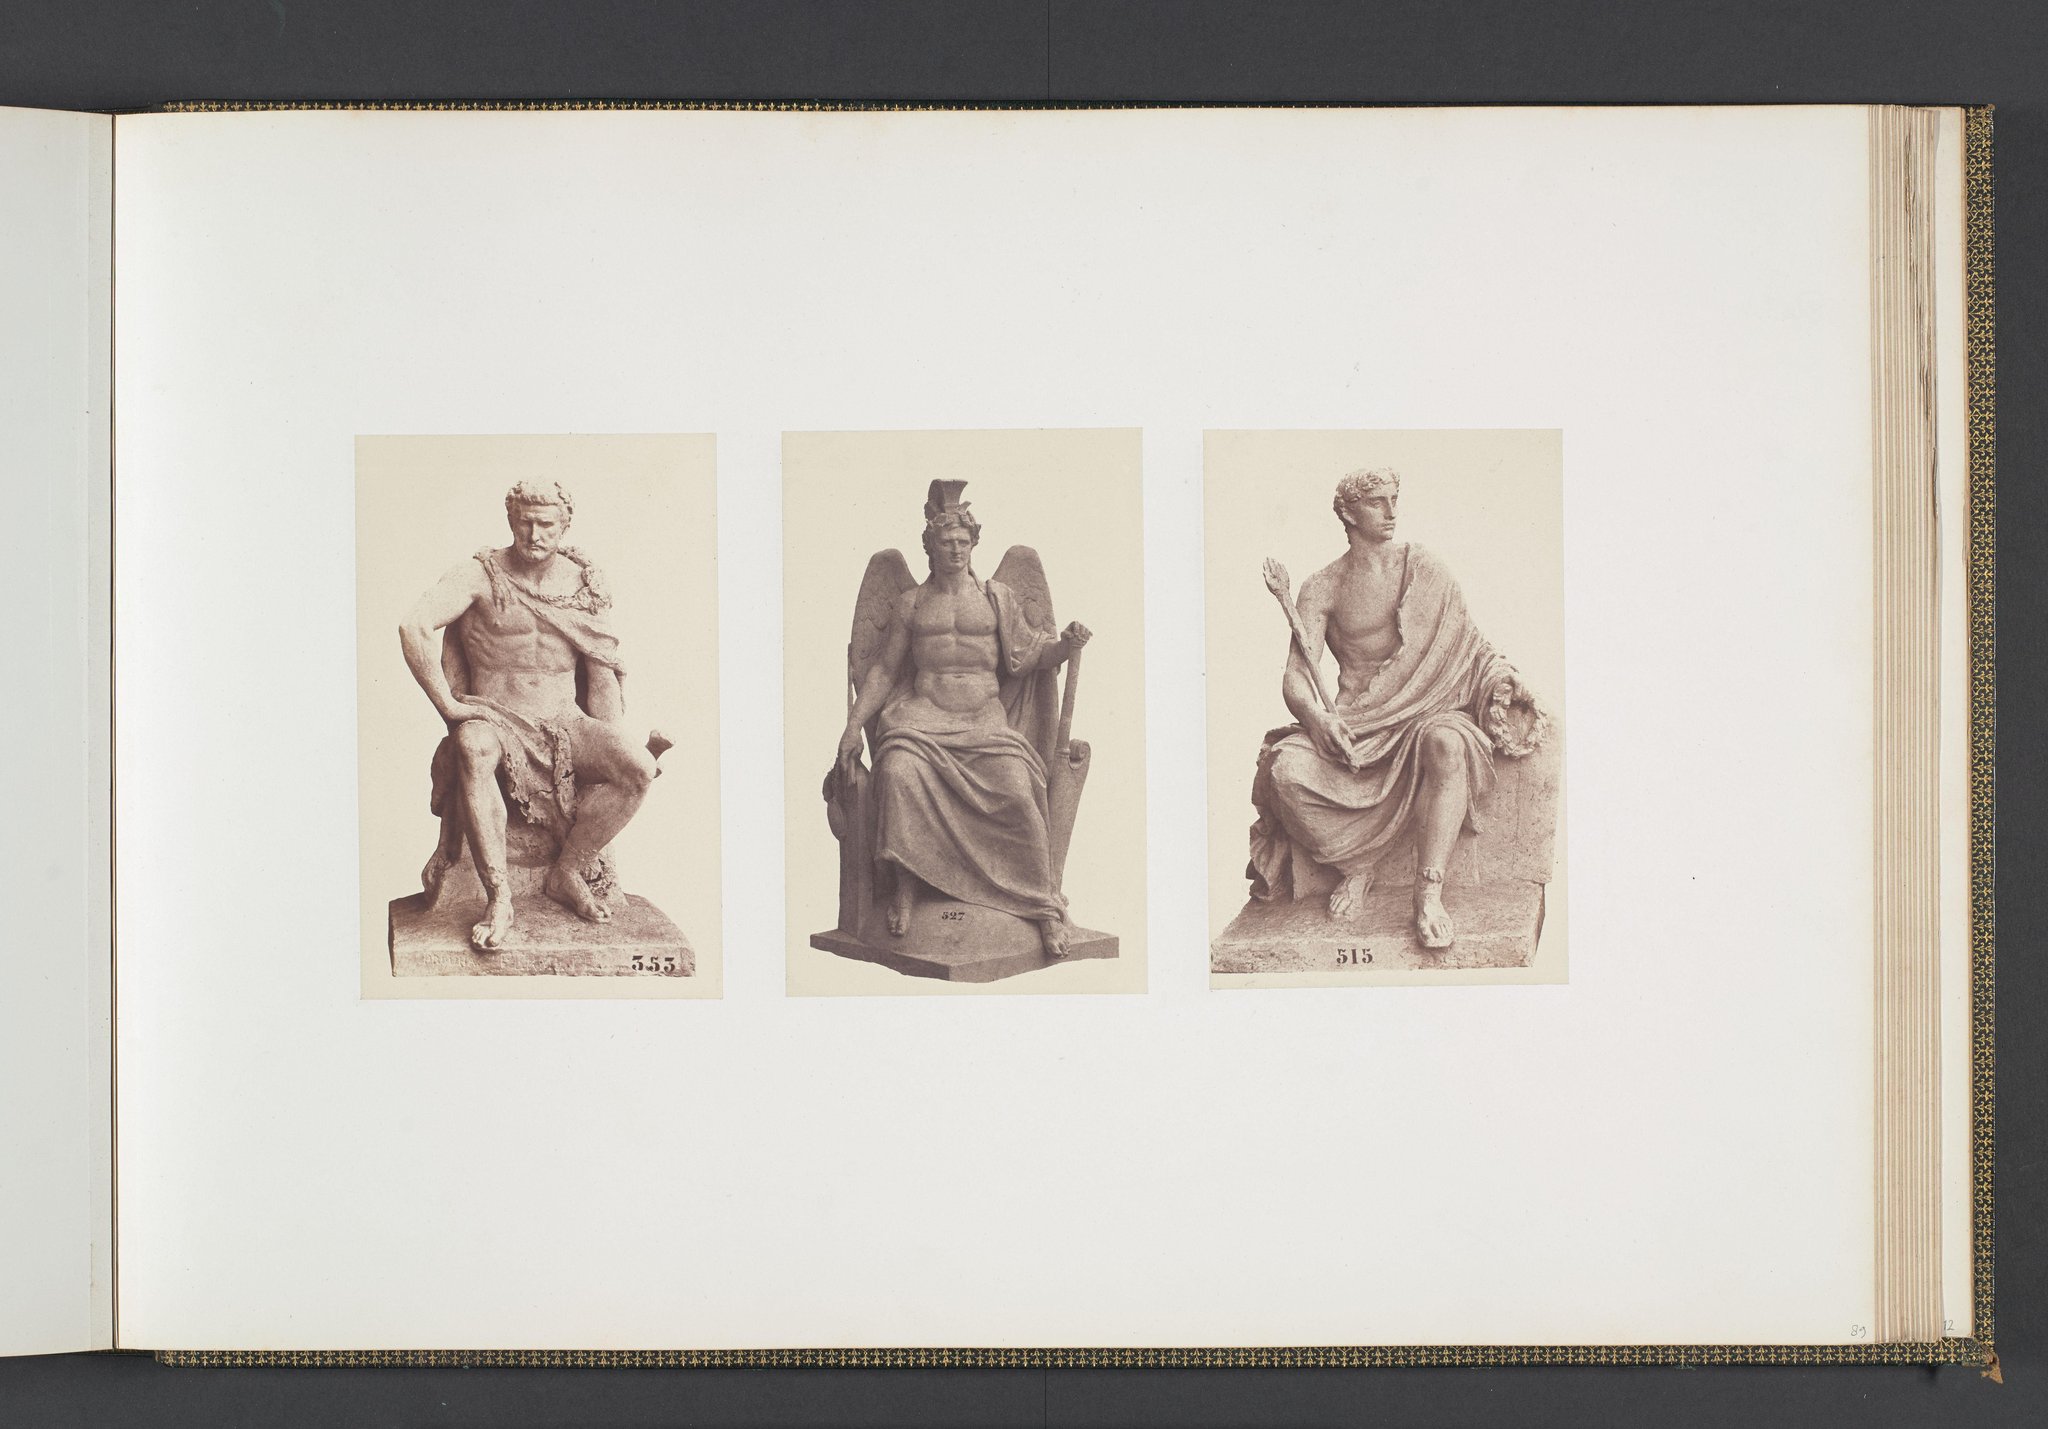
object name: photograph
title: Gipsmodellen voor beeldhouwwerken op het Palais du Louvre: links "La Fermeté" door Pierre-Bernard Prouhaen, midden "La Puissance" door Antoine Laurent Dantan en rechts "La Justice" door Camille Demesnay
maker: édouard denis baldus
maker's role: fotograaf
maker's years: 1813-1889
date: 1855-1857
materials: paper, photographic support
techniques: salted paper print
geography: paris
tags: piece of sculpture, reproduction of a piece of sculpture, permanent exhibition, museum, paris, tuileries palace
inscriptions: number: ‘353, 527 en 515’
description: Onderdeel van Réunion des Tuileries au Louvre 1852-1857, album 2.